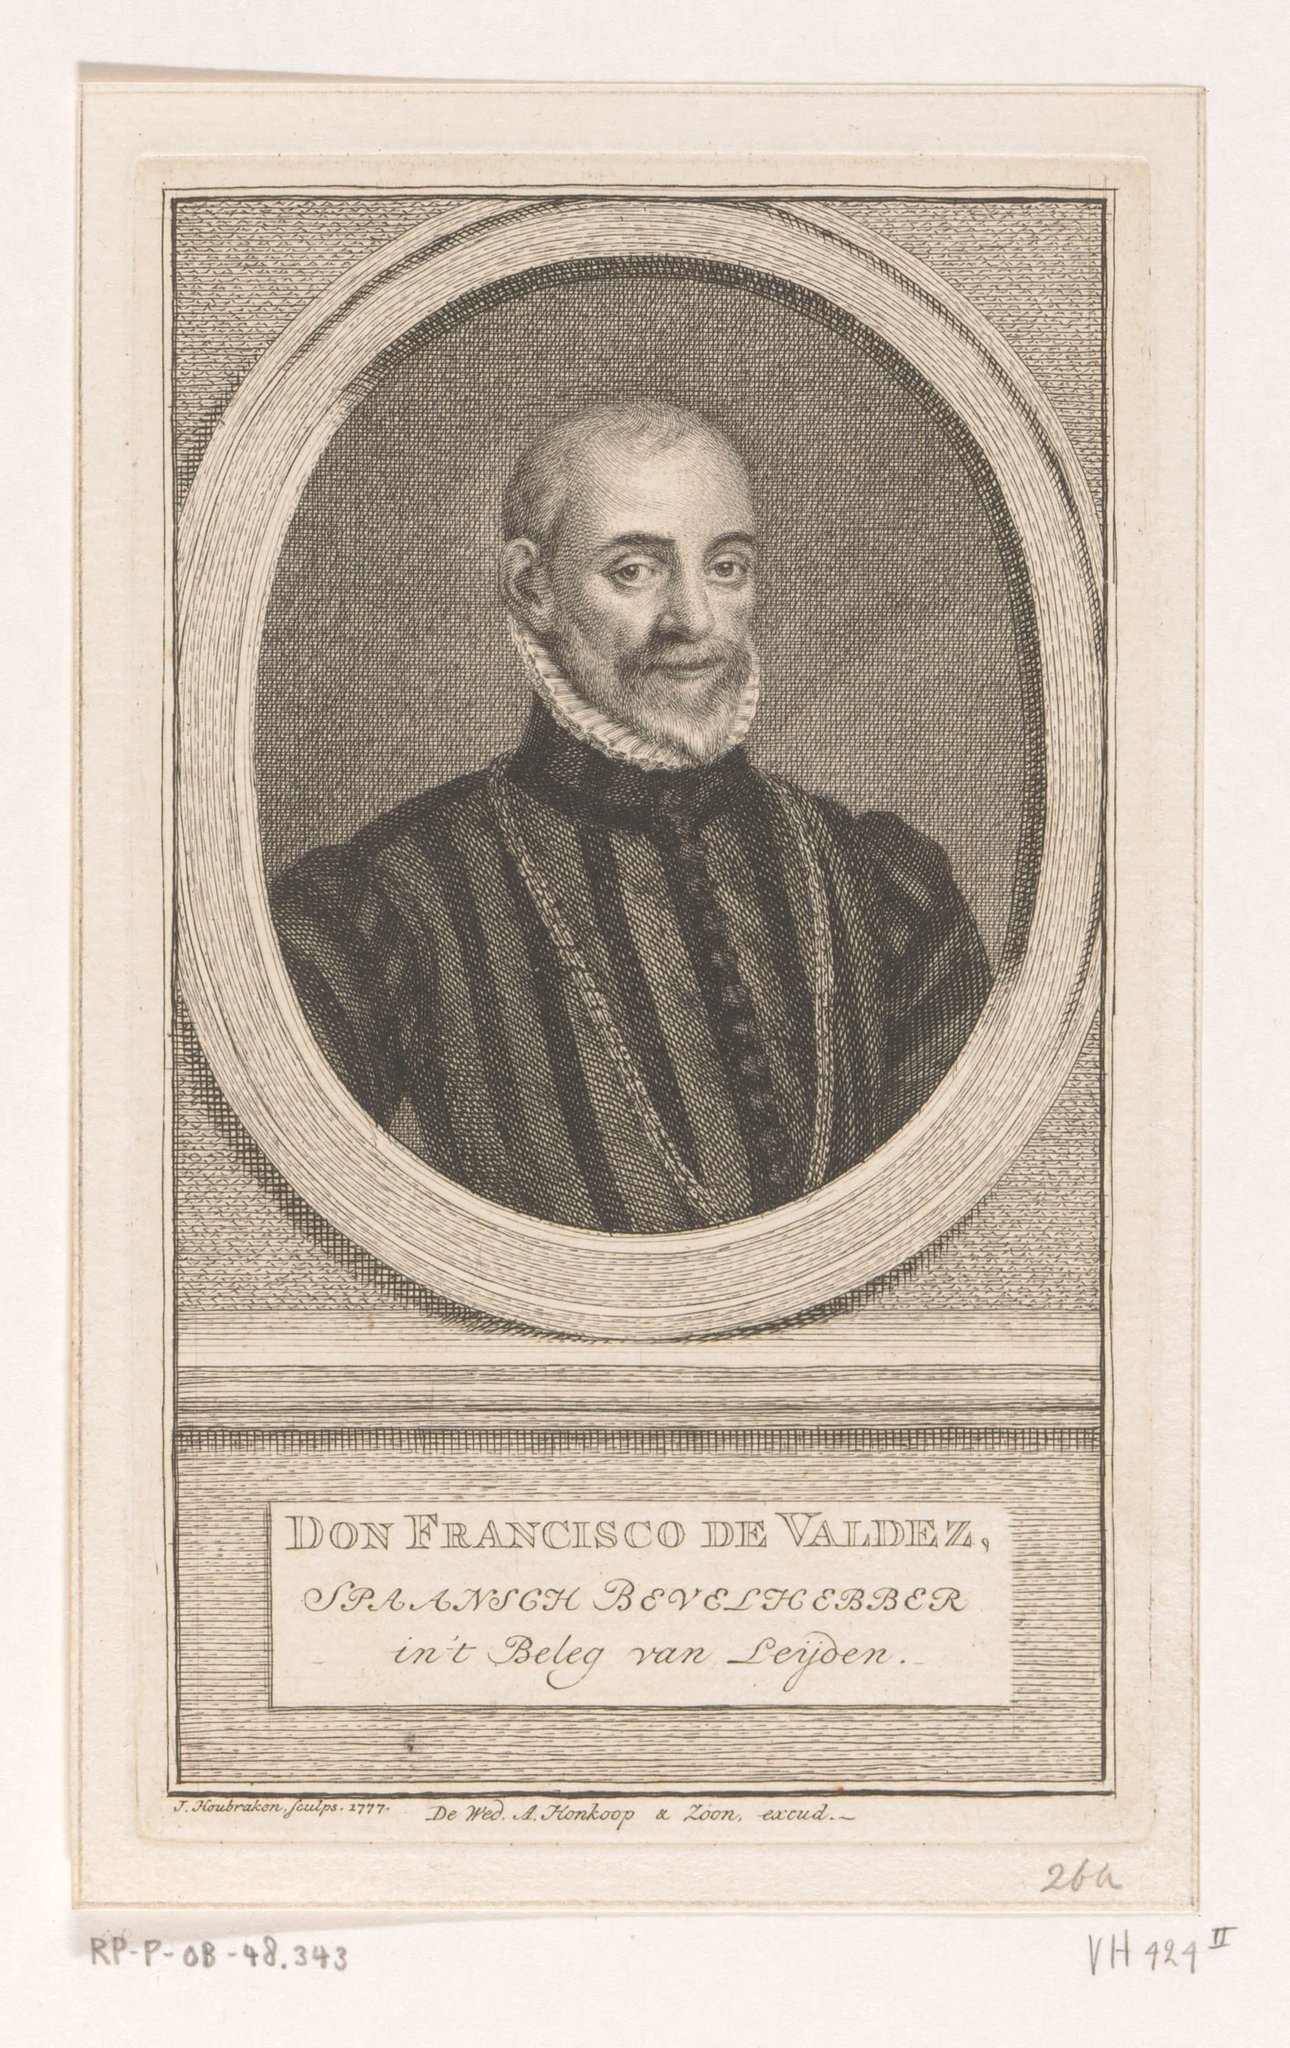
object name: print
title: Don Francisco de Valdez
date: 1777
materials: paper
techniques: engraving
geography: leiden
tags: veldheer, francisco de valdez, beleg van leiden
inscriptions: collector's mark: Lugt 240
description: Volgens Ver Huell prent ook gebruitk in: Adrianus Severinus, Oorspronckelijke beschrijving van de vermaerde belegering en 't ontzet der stad Leiden. Leiden: wed. A. Honkoop en zoon, vijfde editie, 1777.